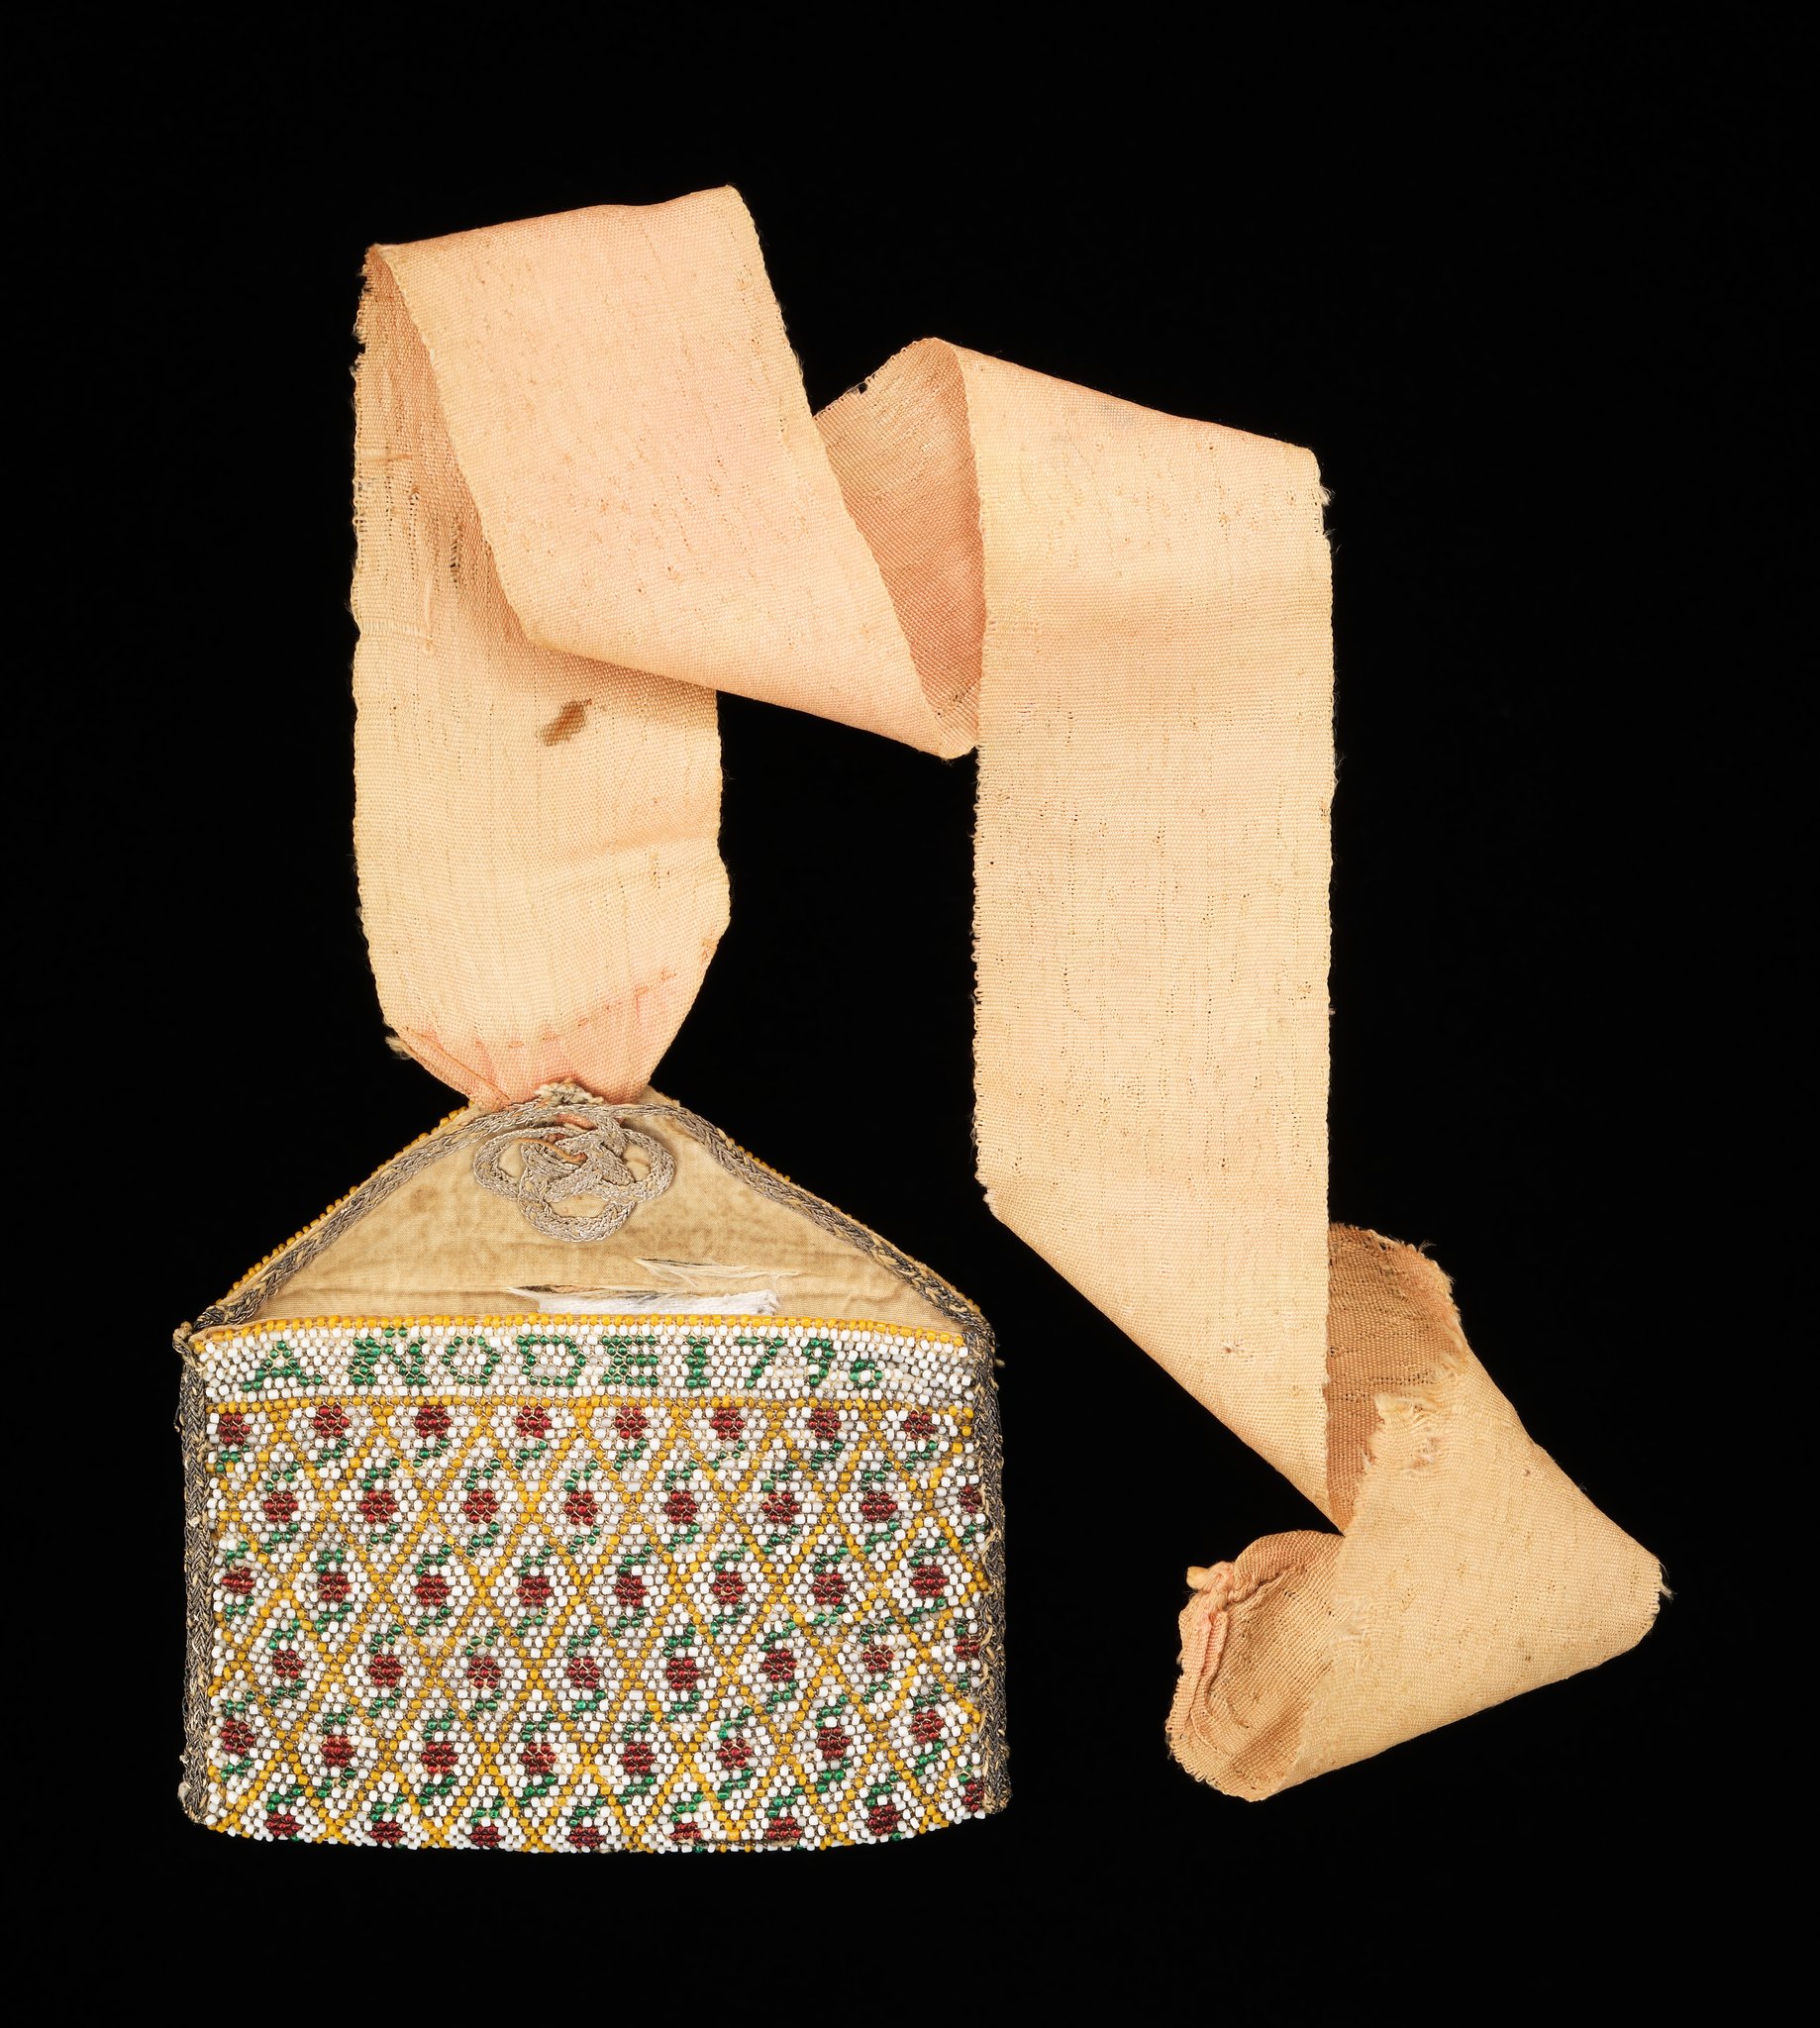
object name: coin purse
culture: mexican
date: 1790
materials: glass, linen, metal, silk